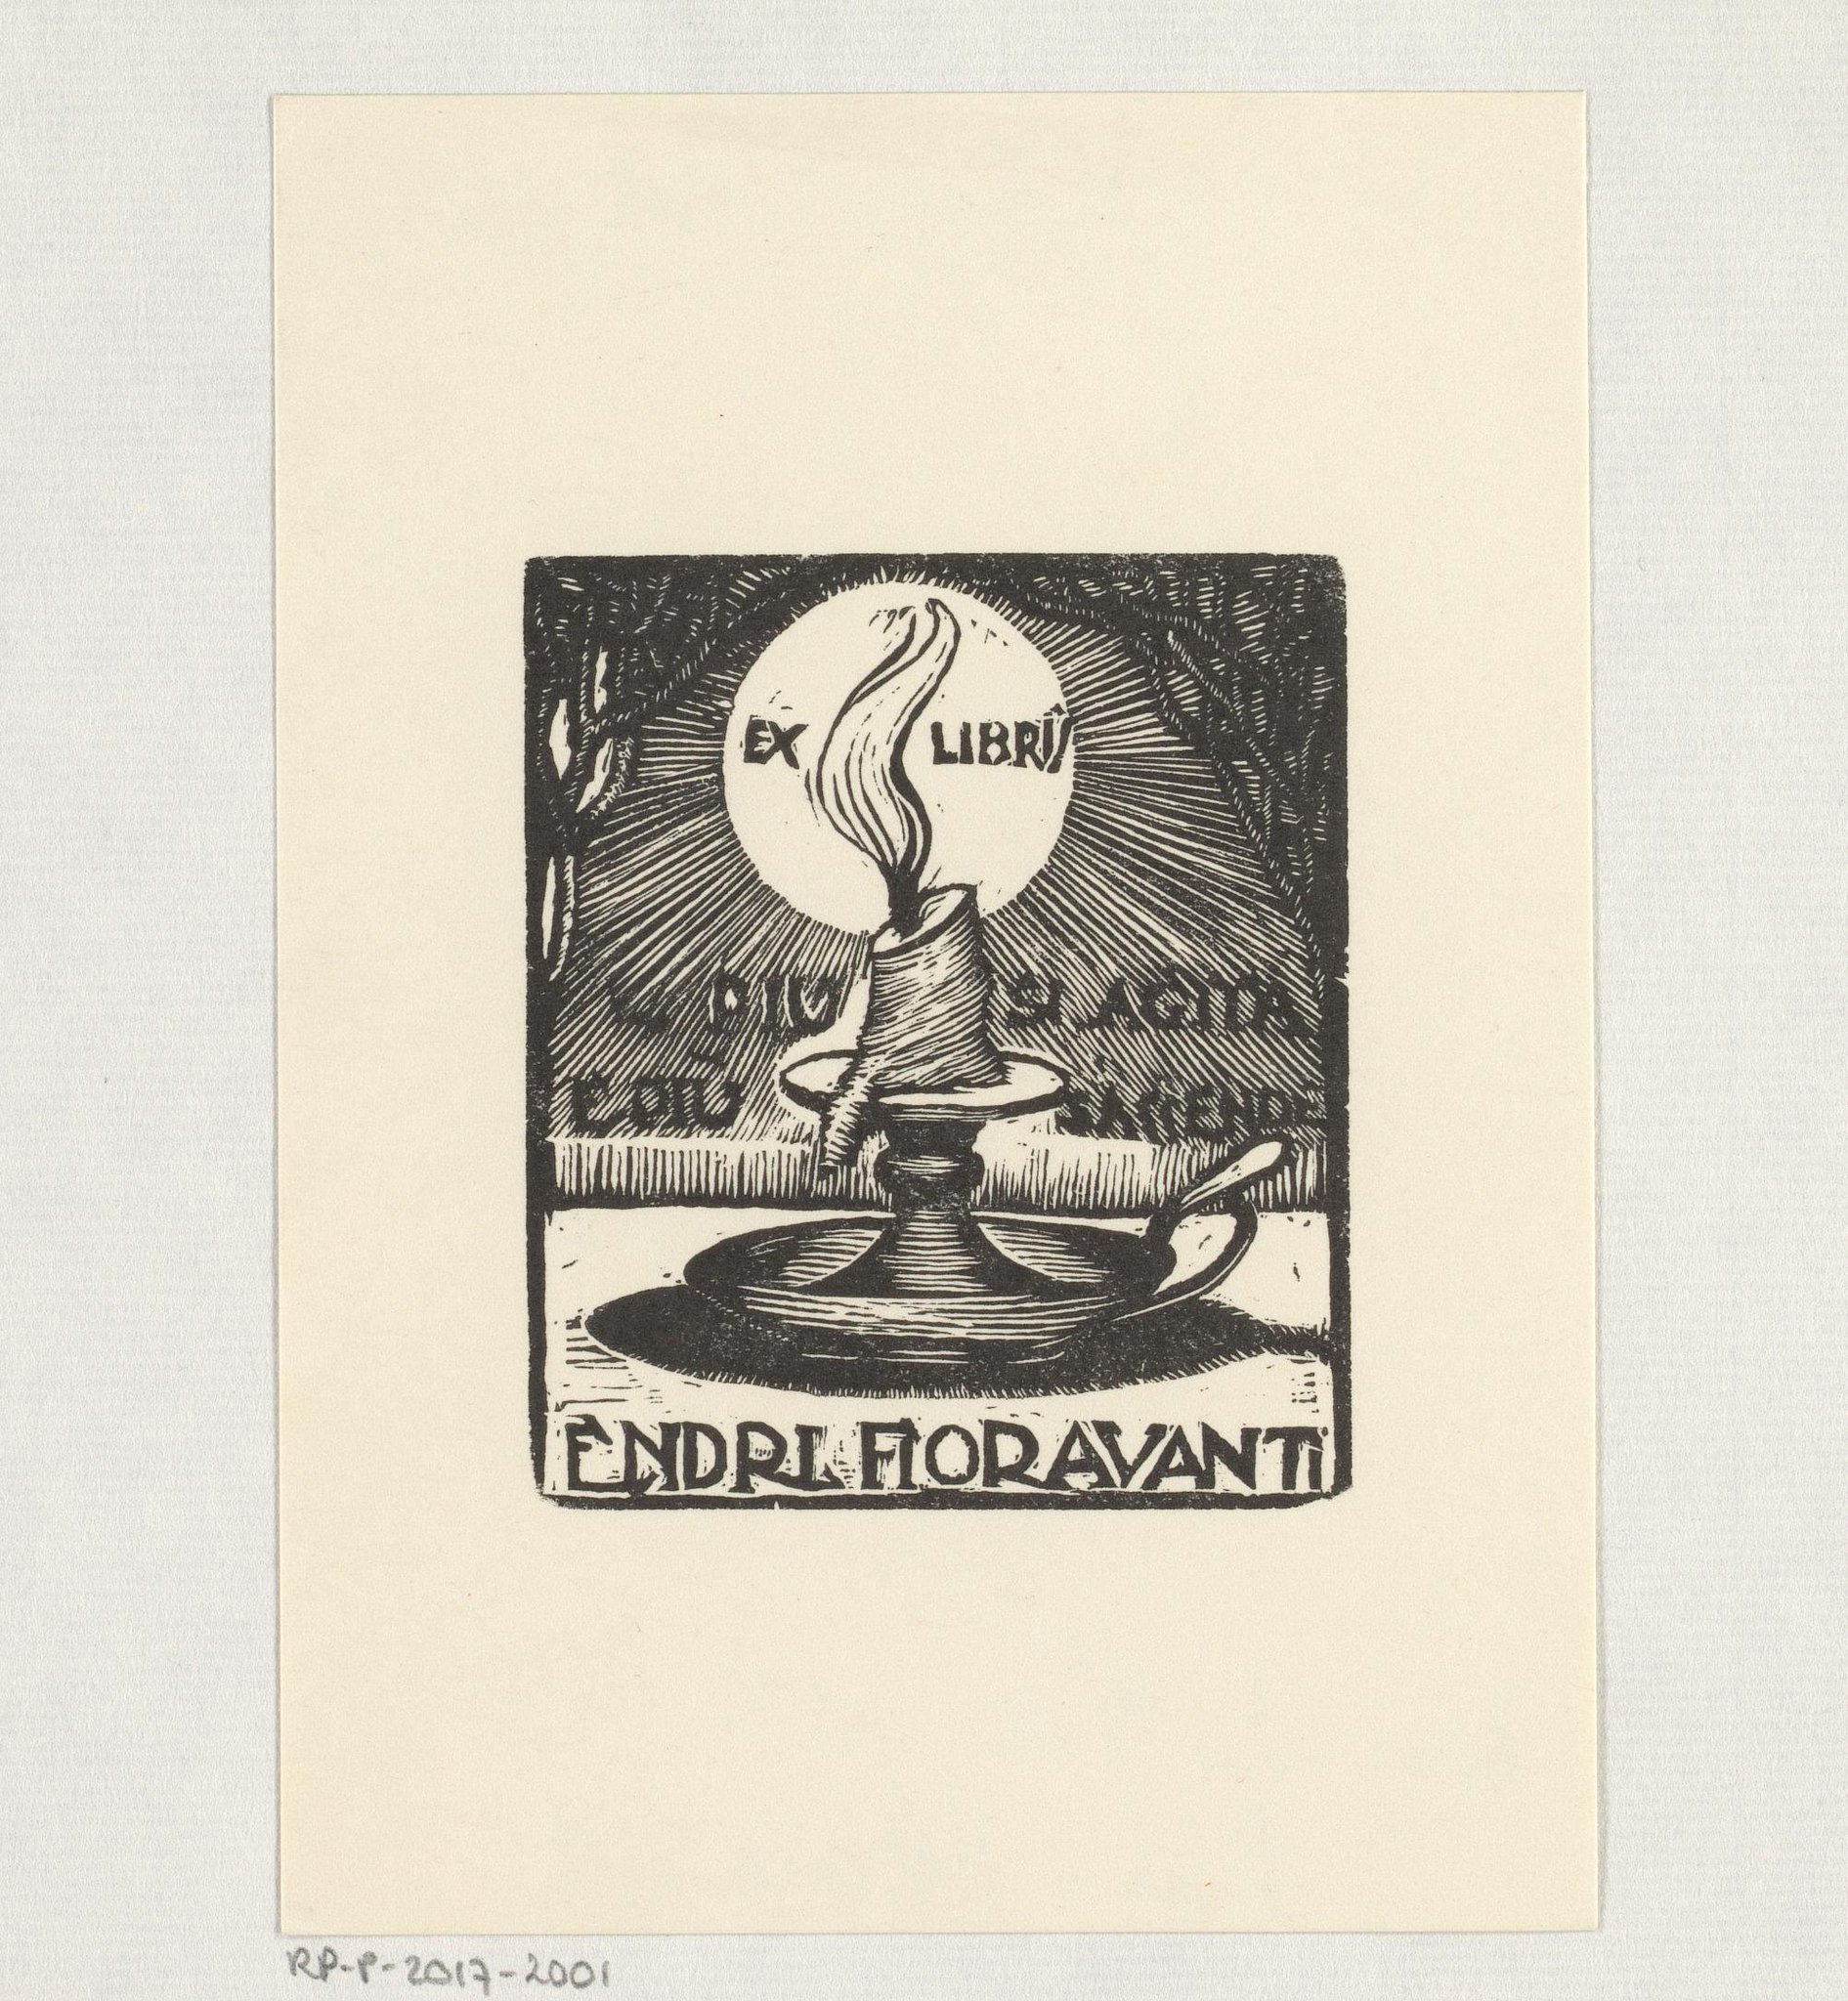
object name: bookplate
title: Piu si agita è più s'arrende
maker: eduardo fioravanti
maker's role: print maker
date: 1900-1999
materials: paper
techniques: woodcut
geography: italy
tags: candle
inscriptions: inscription: ‘Eduardi Fioravanti (Holzschnitt) / Bois-Holzschnitt’